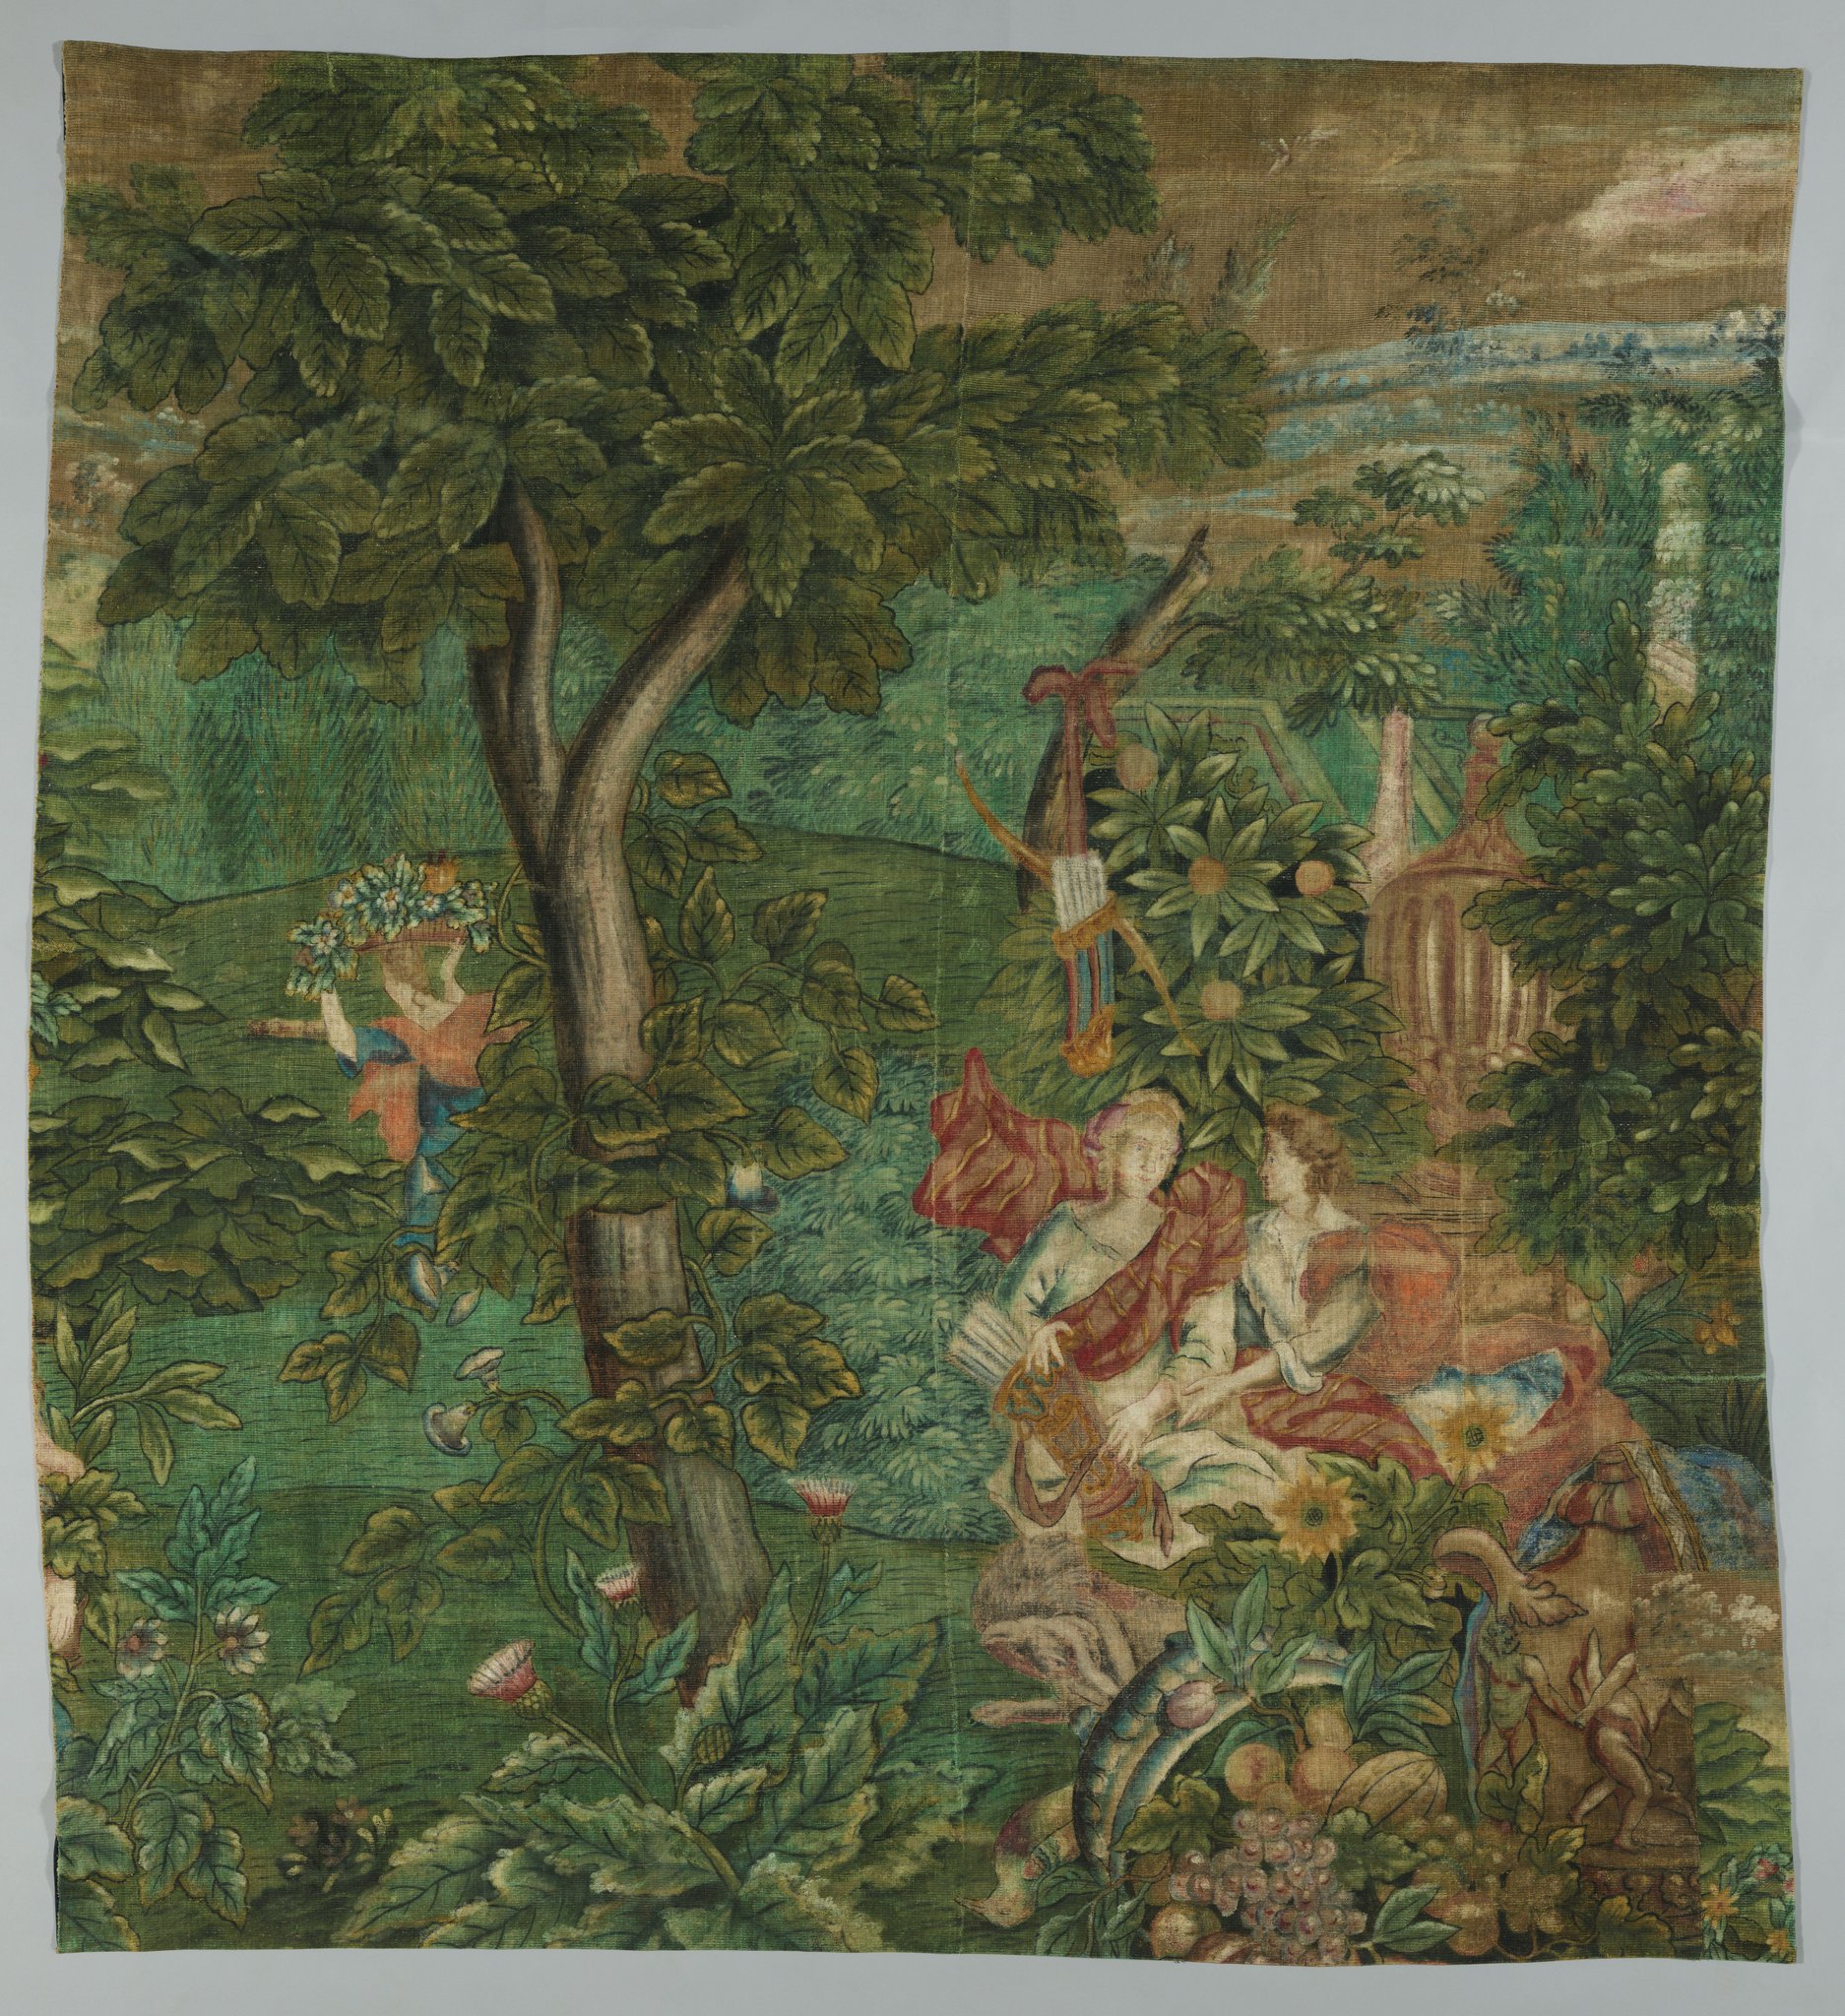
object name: interieuronderdeel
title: Wandbespanning van grove jute met voorstelling van Diana in boslandschap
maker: Anonymous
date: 1785-1800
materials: jute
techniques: painted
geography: northern netherlands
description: Een stuk op grof jute geschilderde wandbespanning, met een voorstelling van Diana in een boslandschap. Zie tevens: BK-10937-a.